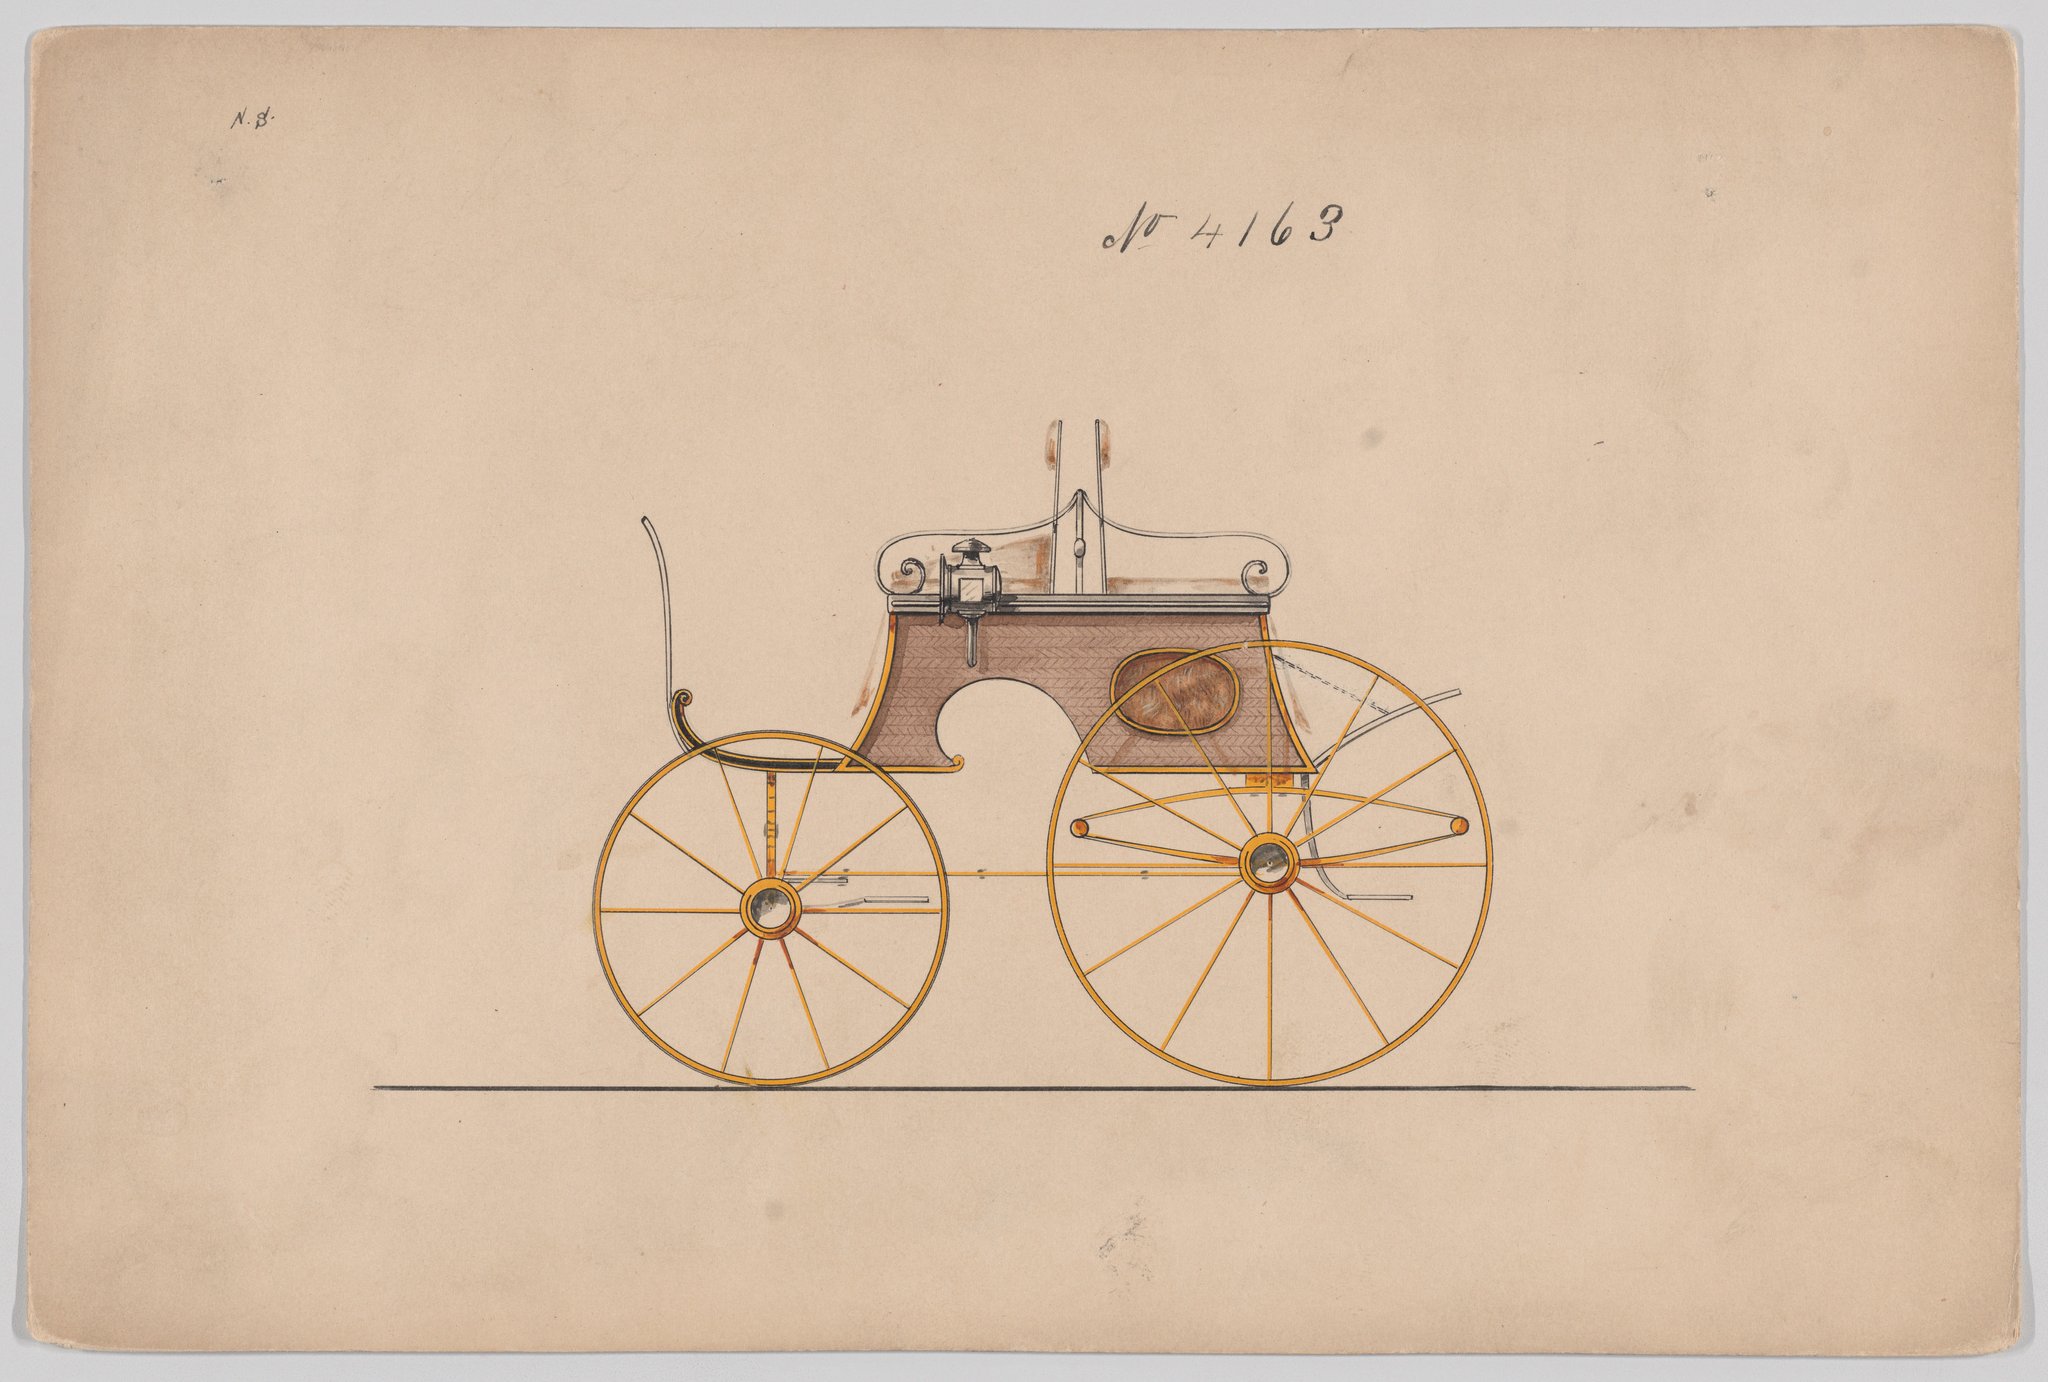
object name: drawing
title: Design for Dog Cart or 2 Wheeler, no. 4163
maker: brewster & co.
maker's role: manufacturer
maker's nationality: american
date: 1892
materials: gouache, ink, watercolor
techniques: pen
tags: carriages